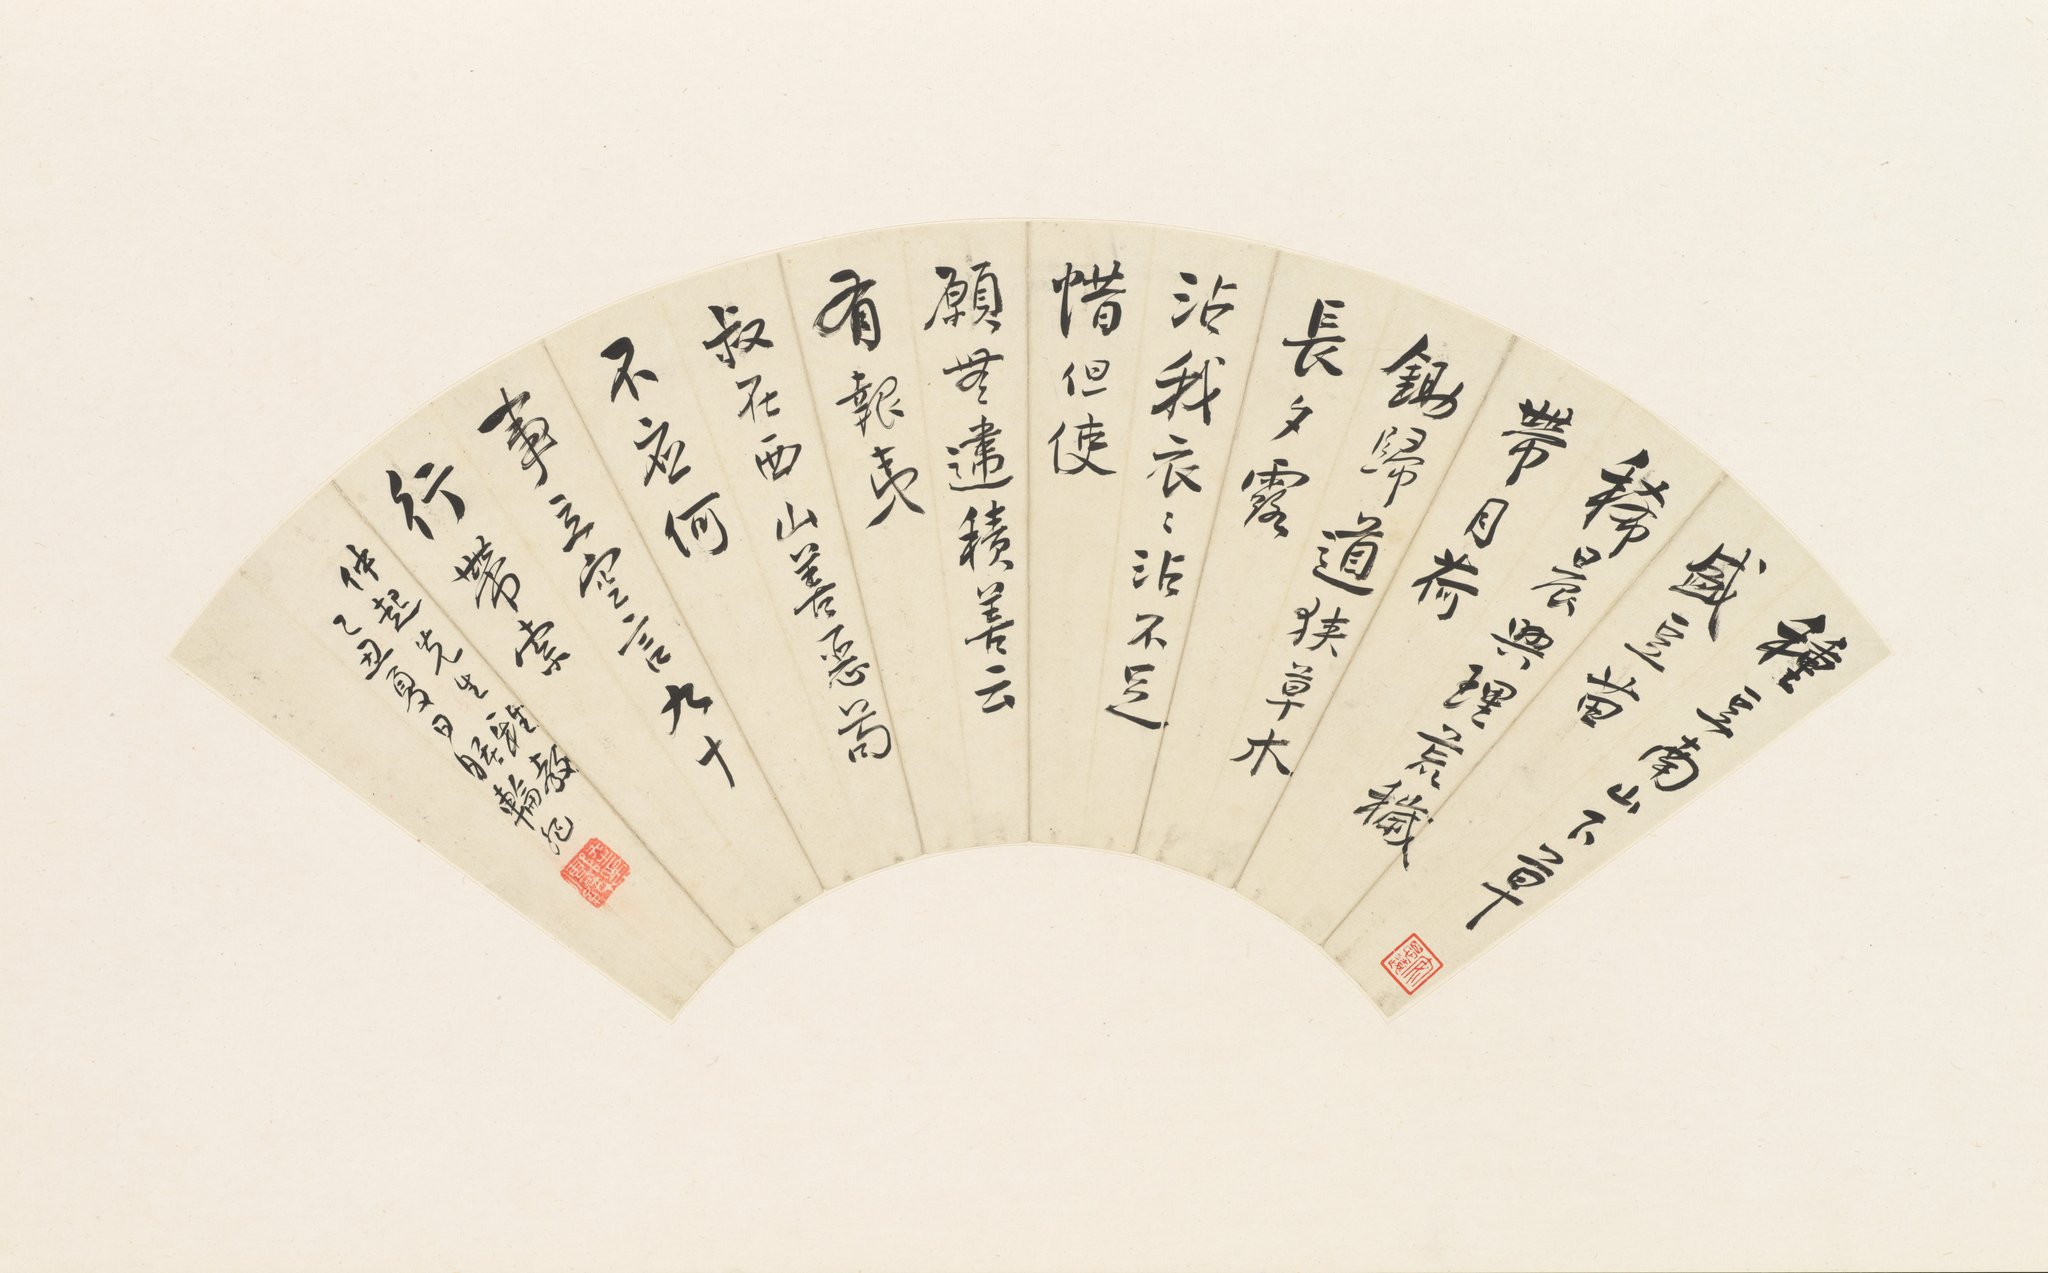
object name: folding fan mounted a an album leaf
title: Poem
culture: chinese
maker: lu lunji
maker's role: artist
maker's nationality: chinese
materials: ink, paper